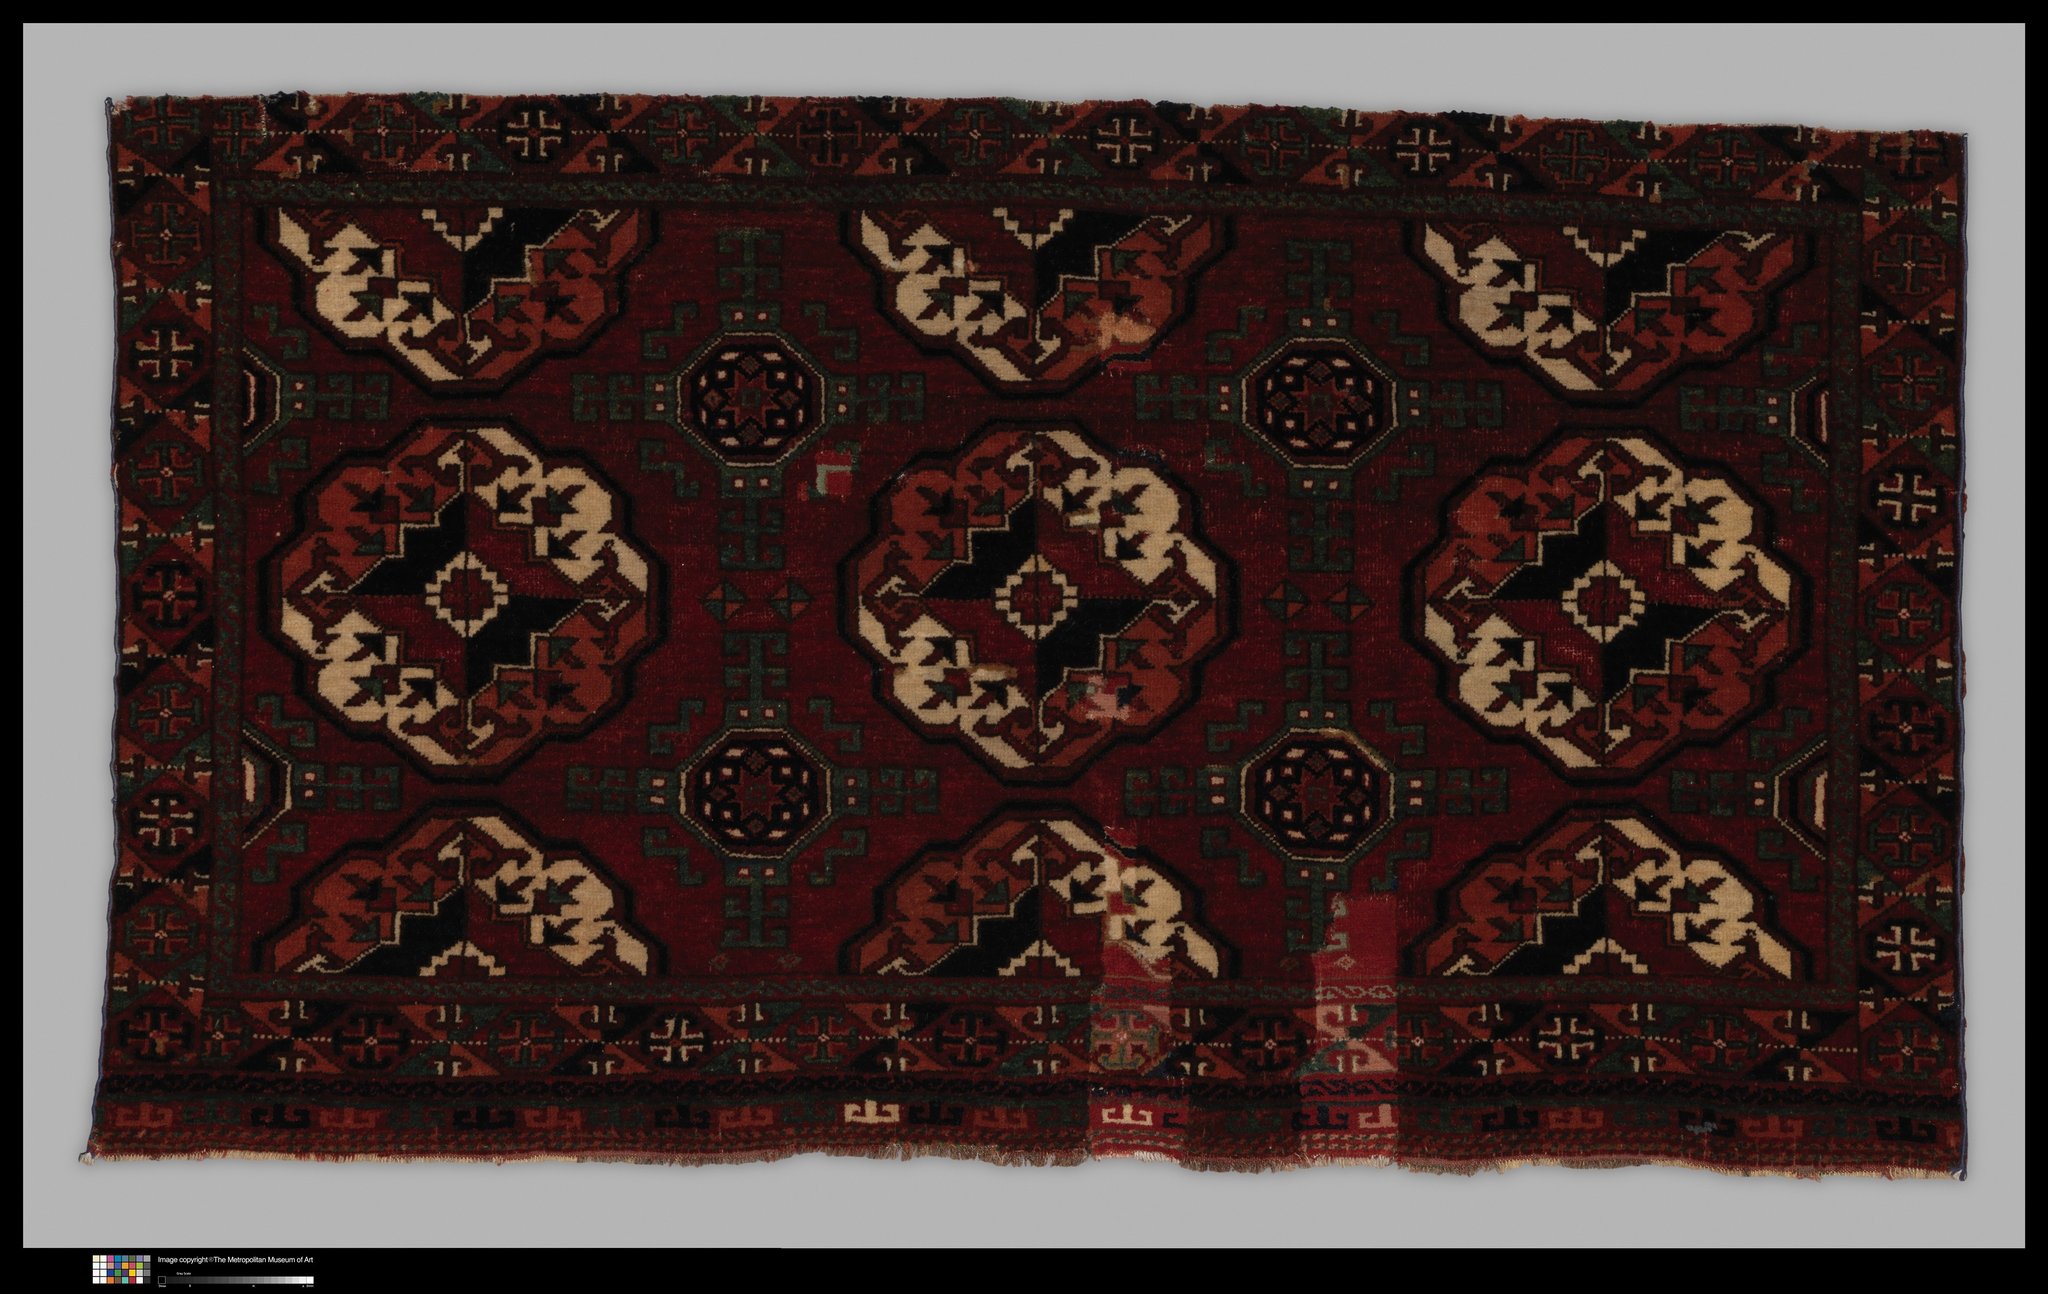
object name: storage bag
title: Storage Bag (Chuval) Face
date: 1801-1833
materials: cotton, wool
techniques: asymmetrically knotted pile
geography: central asia